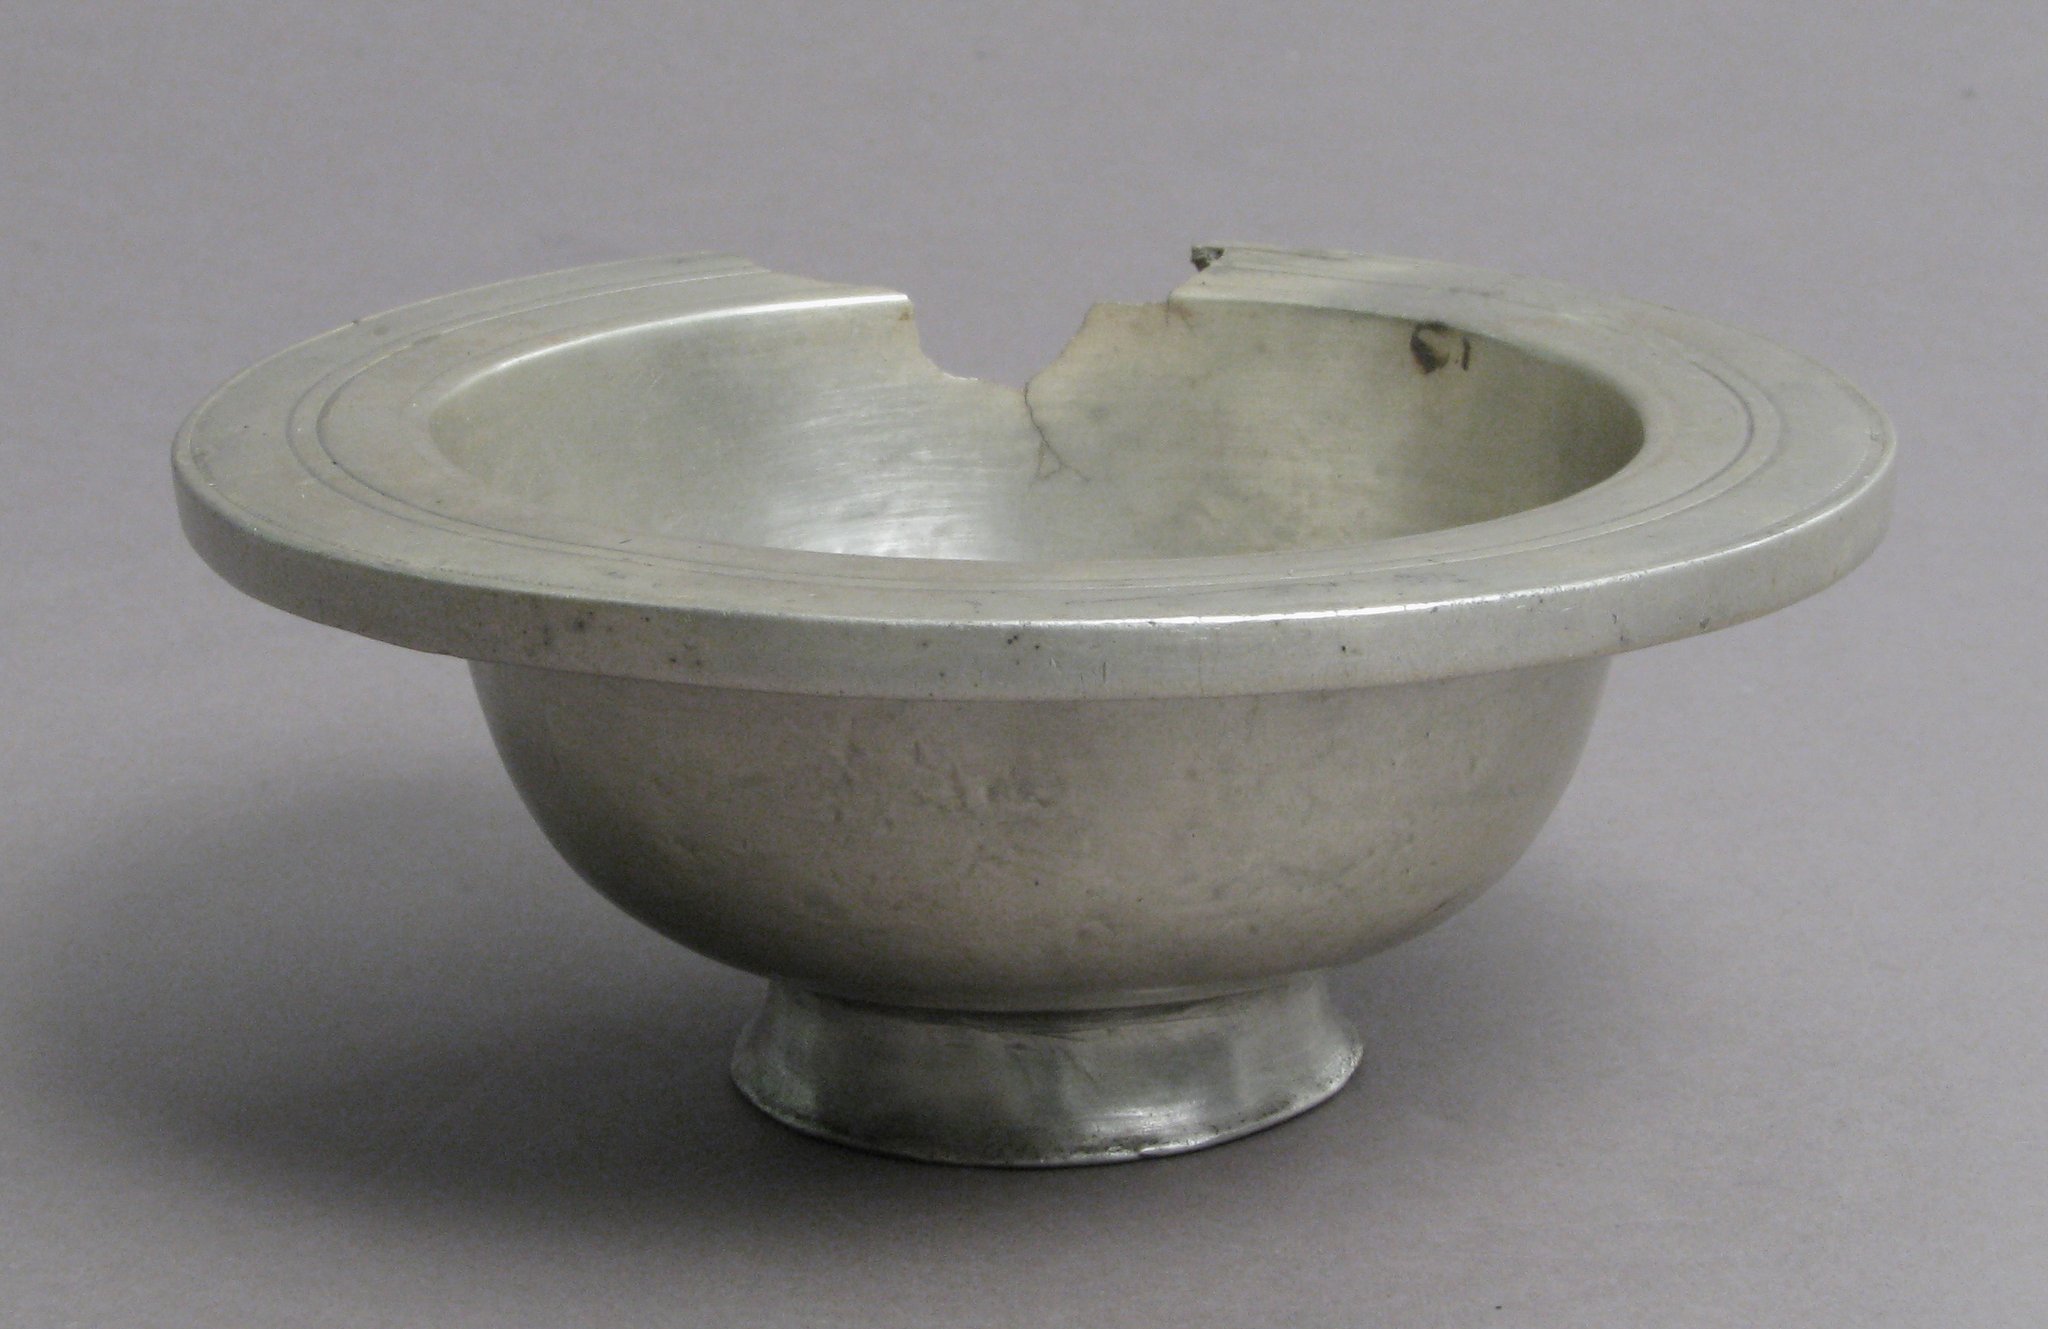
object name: bowl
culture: coptic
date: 301-700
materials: silver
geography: egypt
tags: bowls